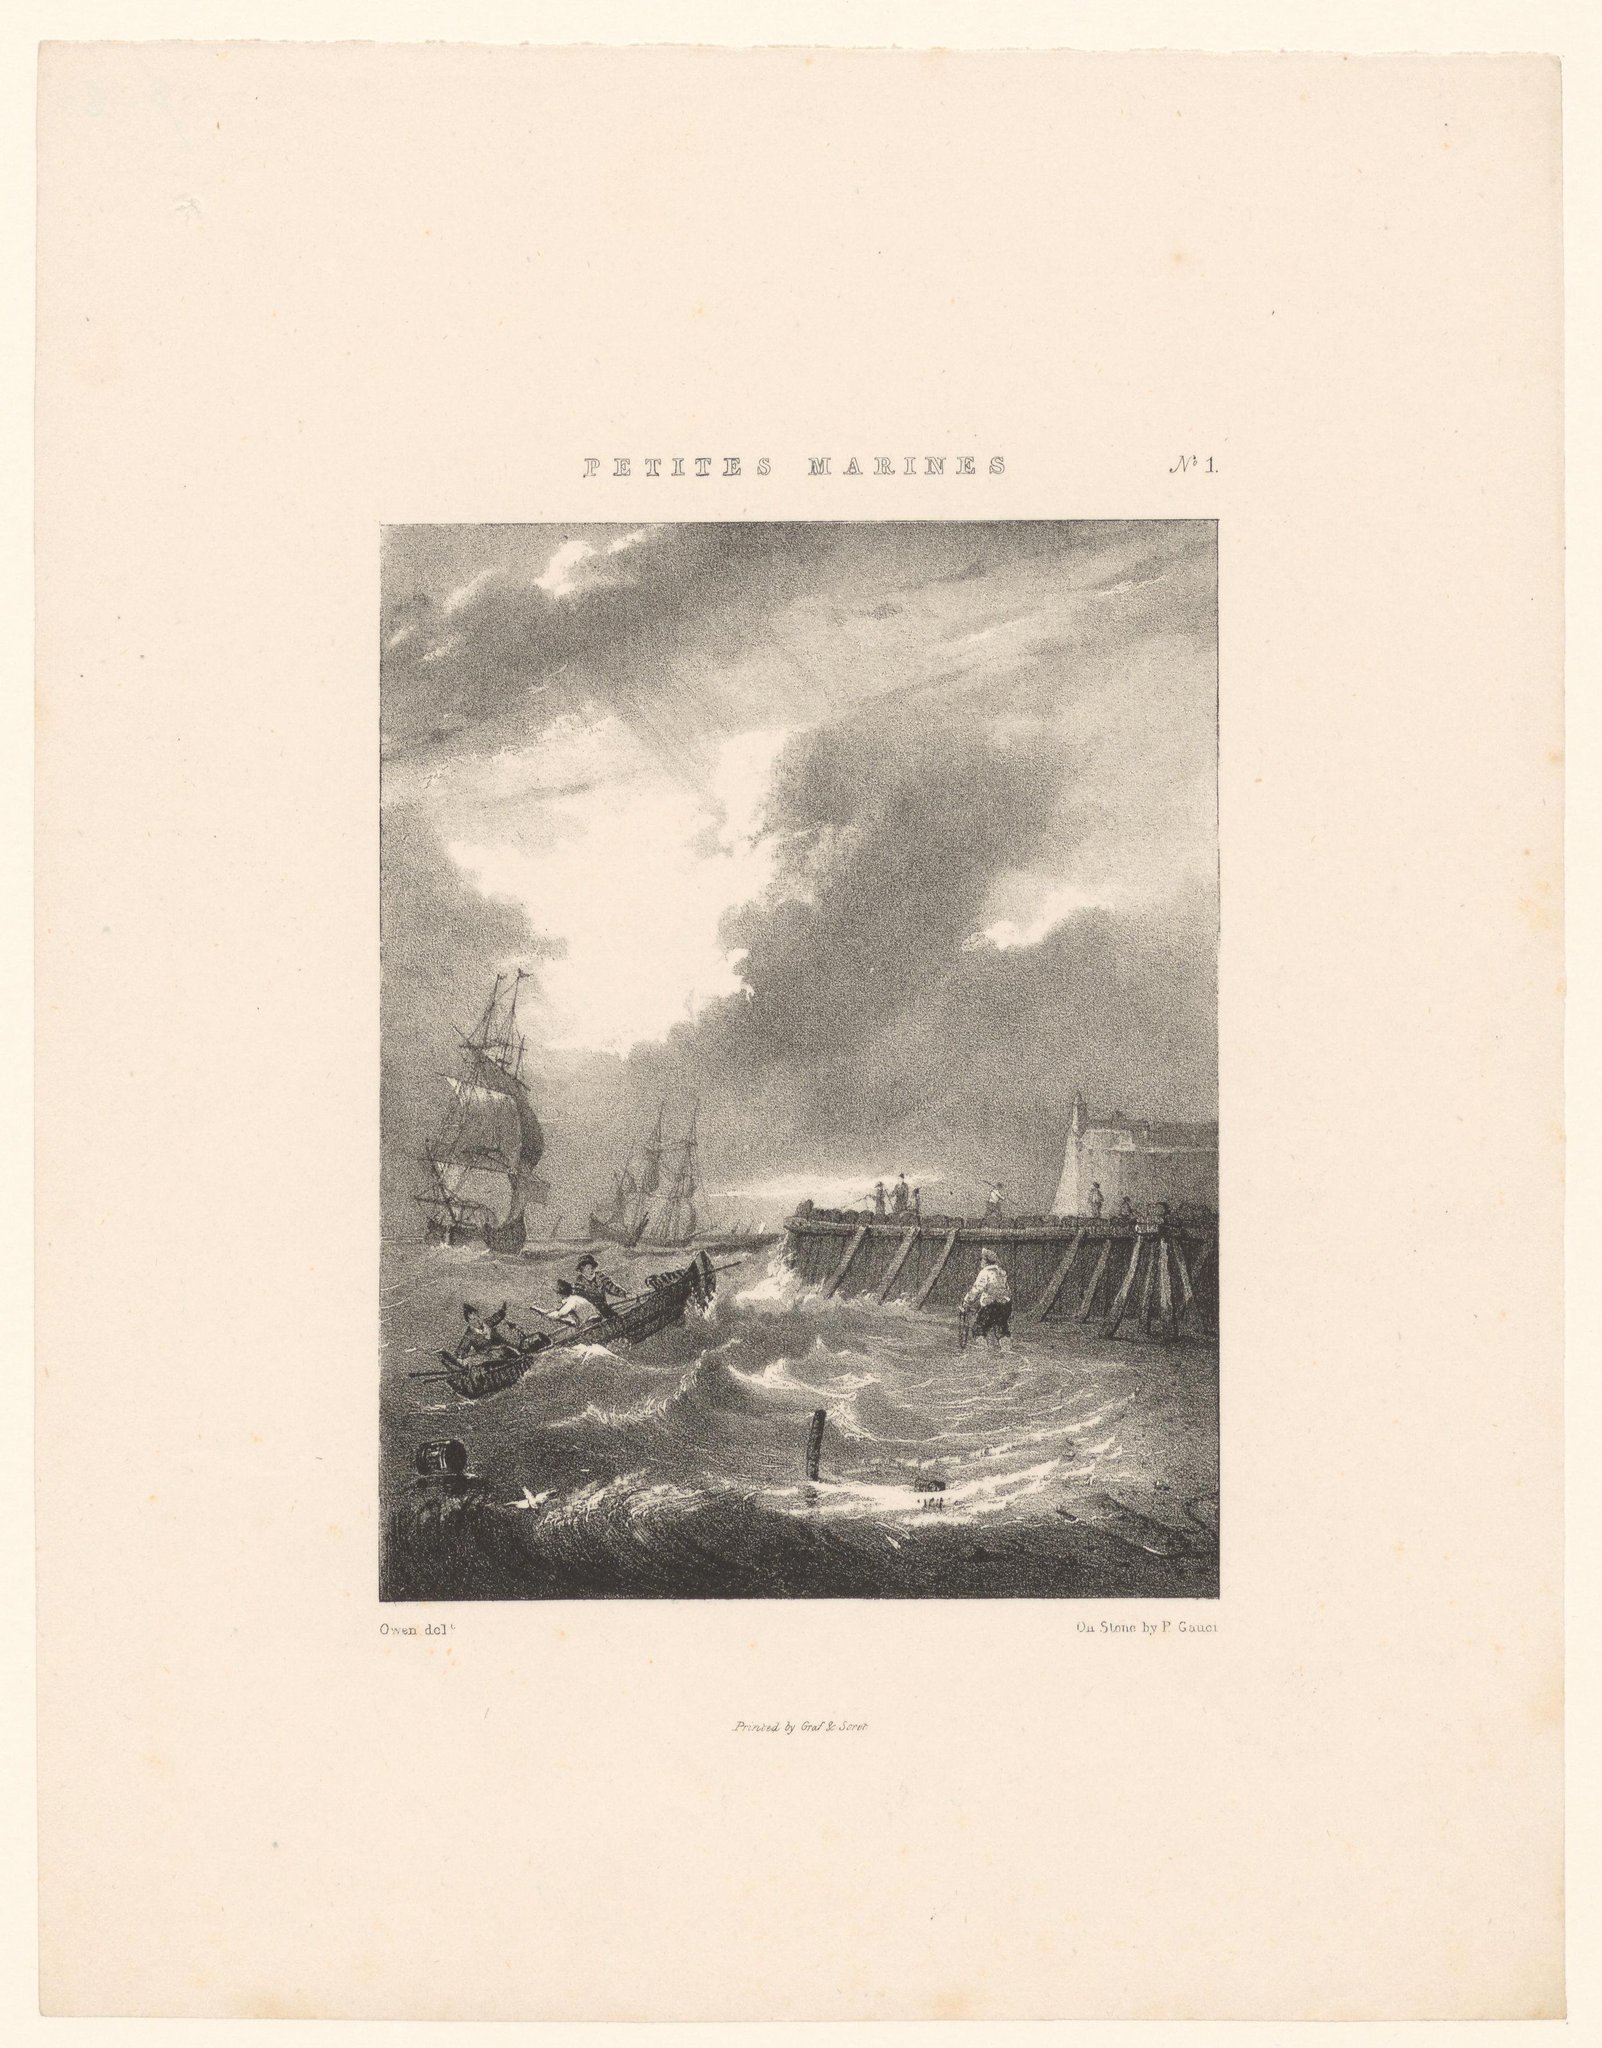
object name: print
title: Petites marines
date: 1834-1866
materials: paper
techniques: lithograph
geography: london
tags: rowing-boat, canoe, etc., pier, quay, wharf, sea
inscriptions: collector's mark: Lugt 2228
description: Prent behoort waarschijnlijk tot de serie 'Petites marines'.